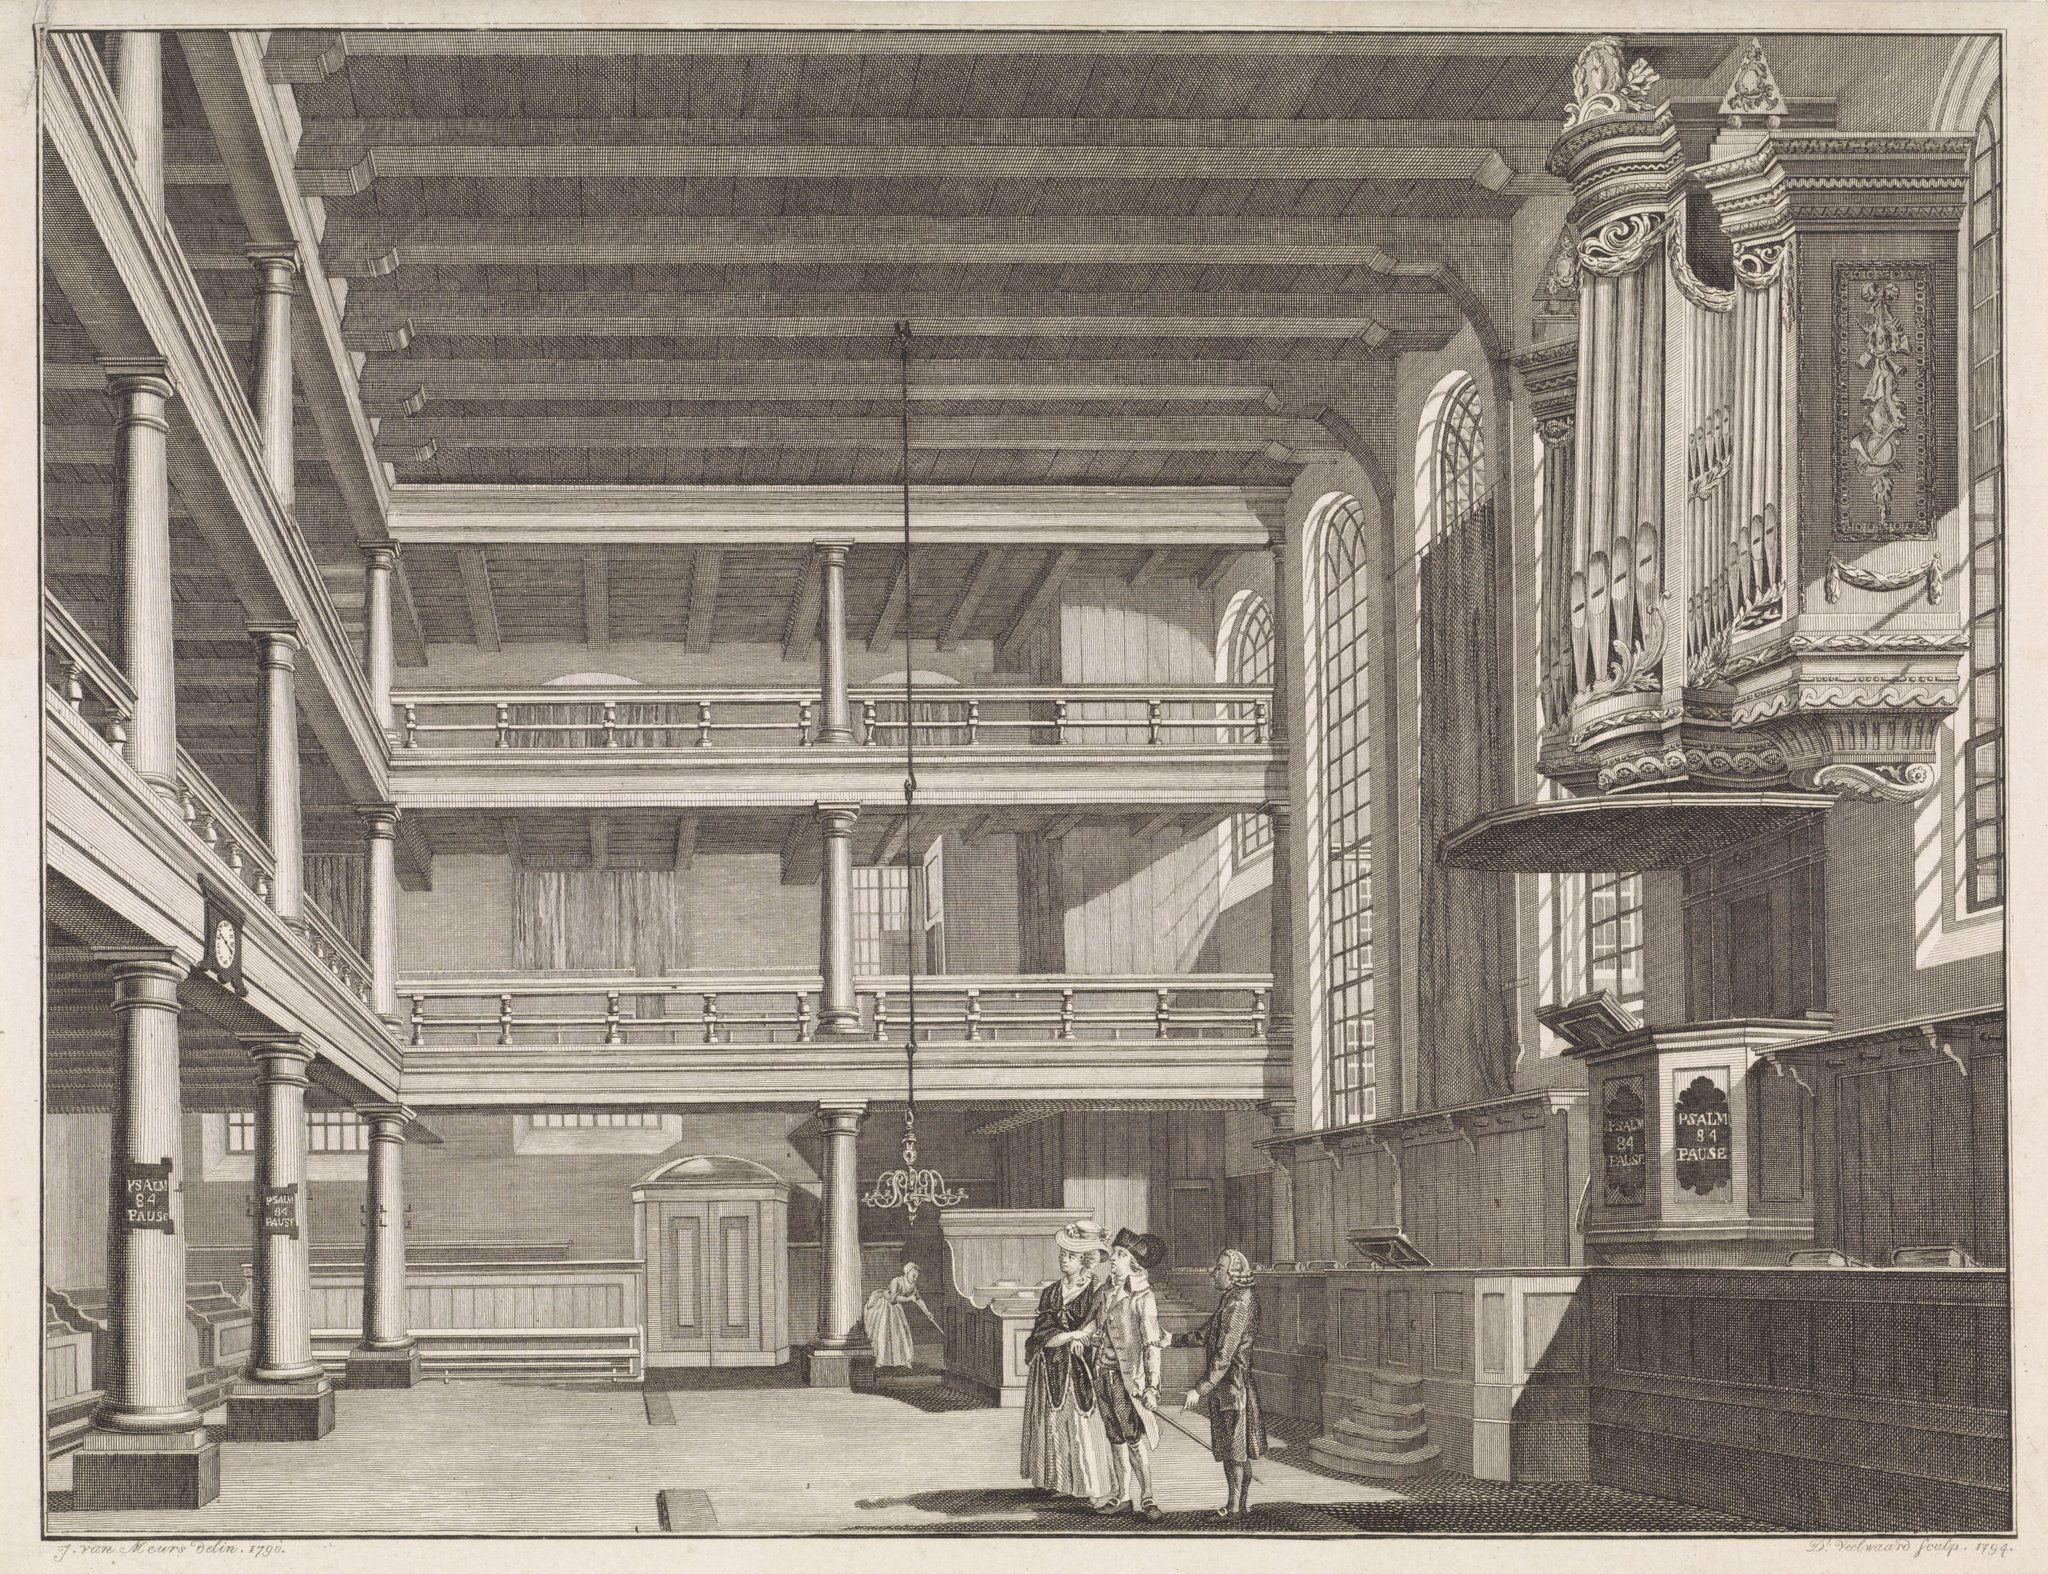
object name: print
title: Interieur van Doopsgezinde Kerk Bij 't Lam, Amsterdam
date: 1794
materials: paper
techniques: engraving, etching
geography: amsterdam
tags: interior of church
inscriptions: collector's mark: Lugt 2228